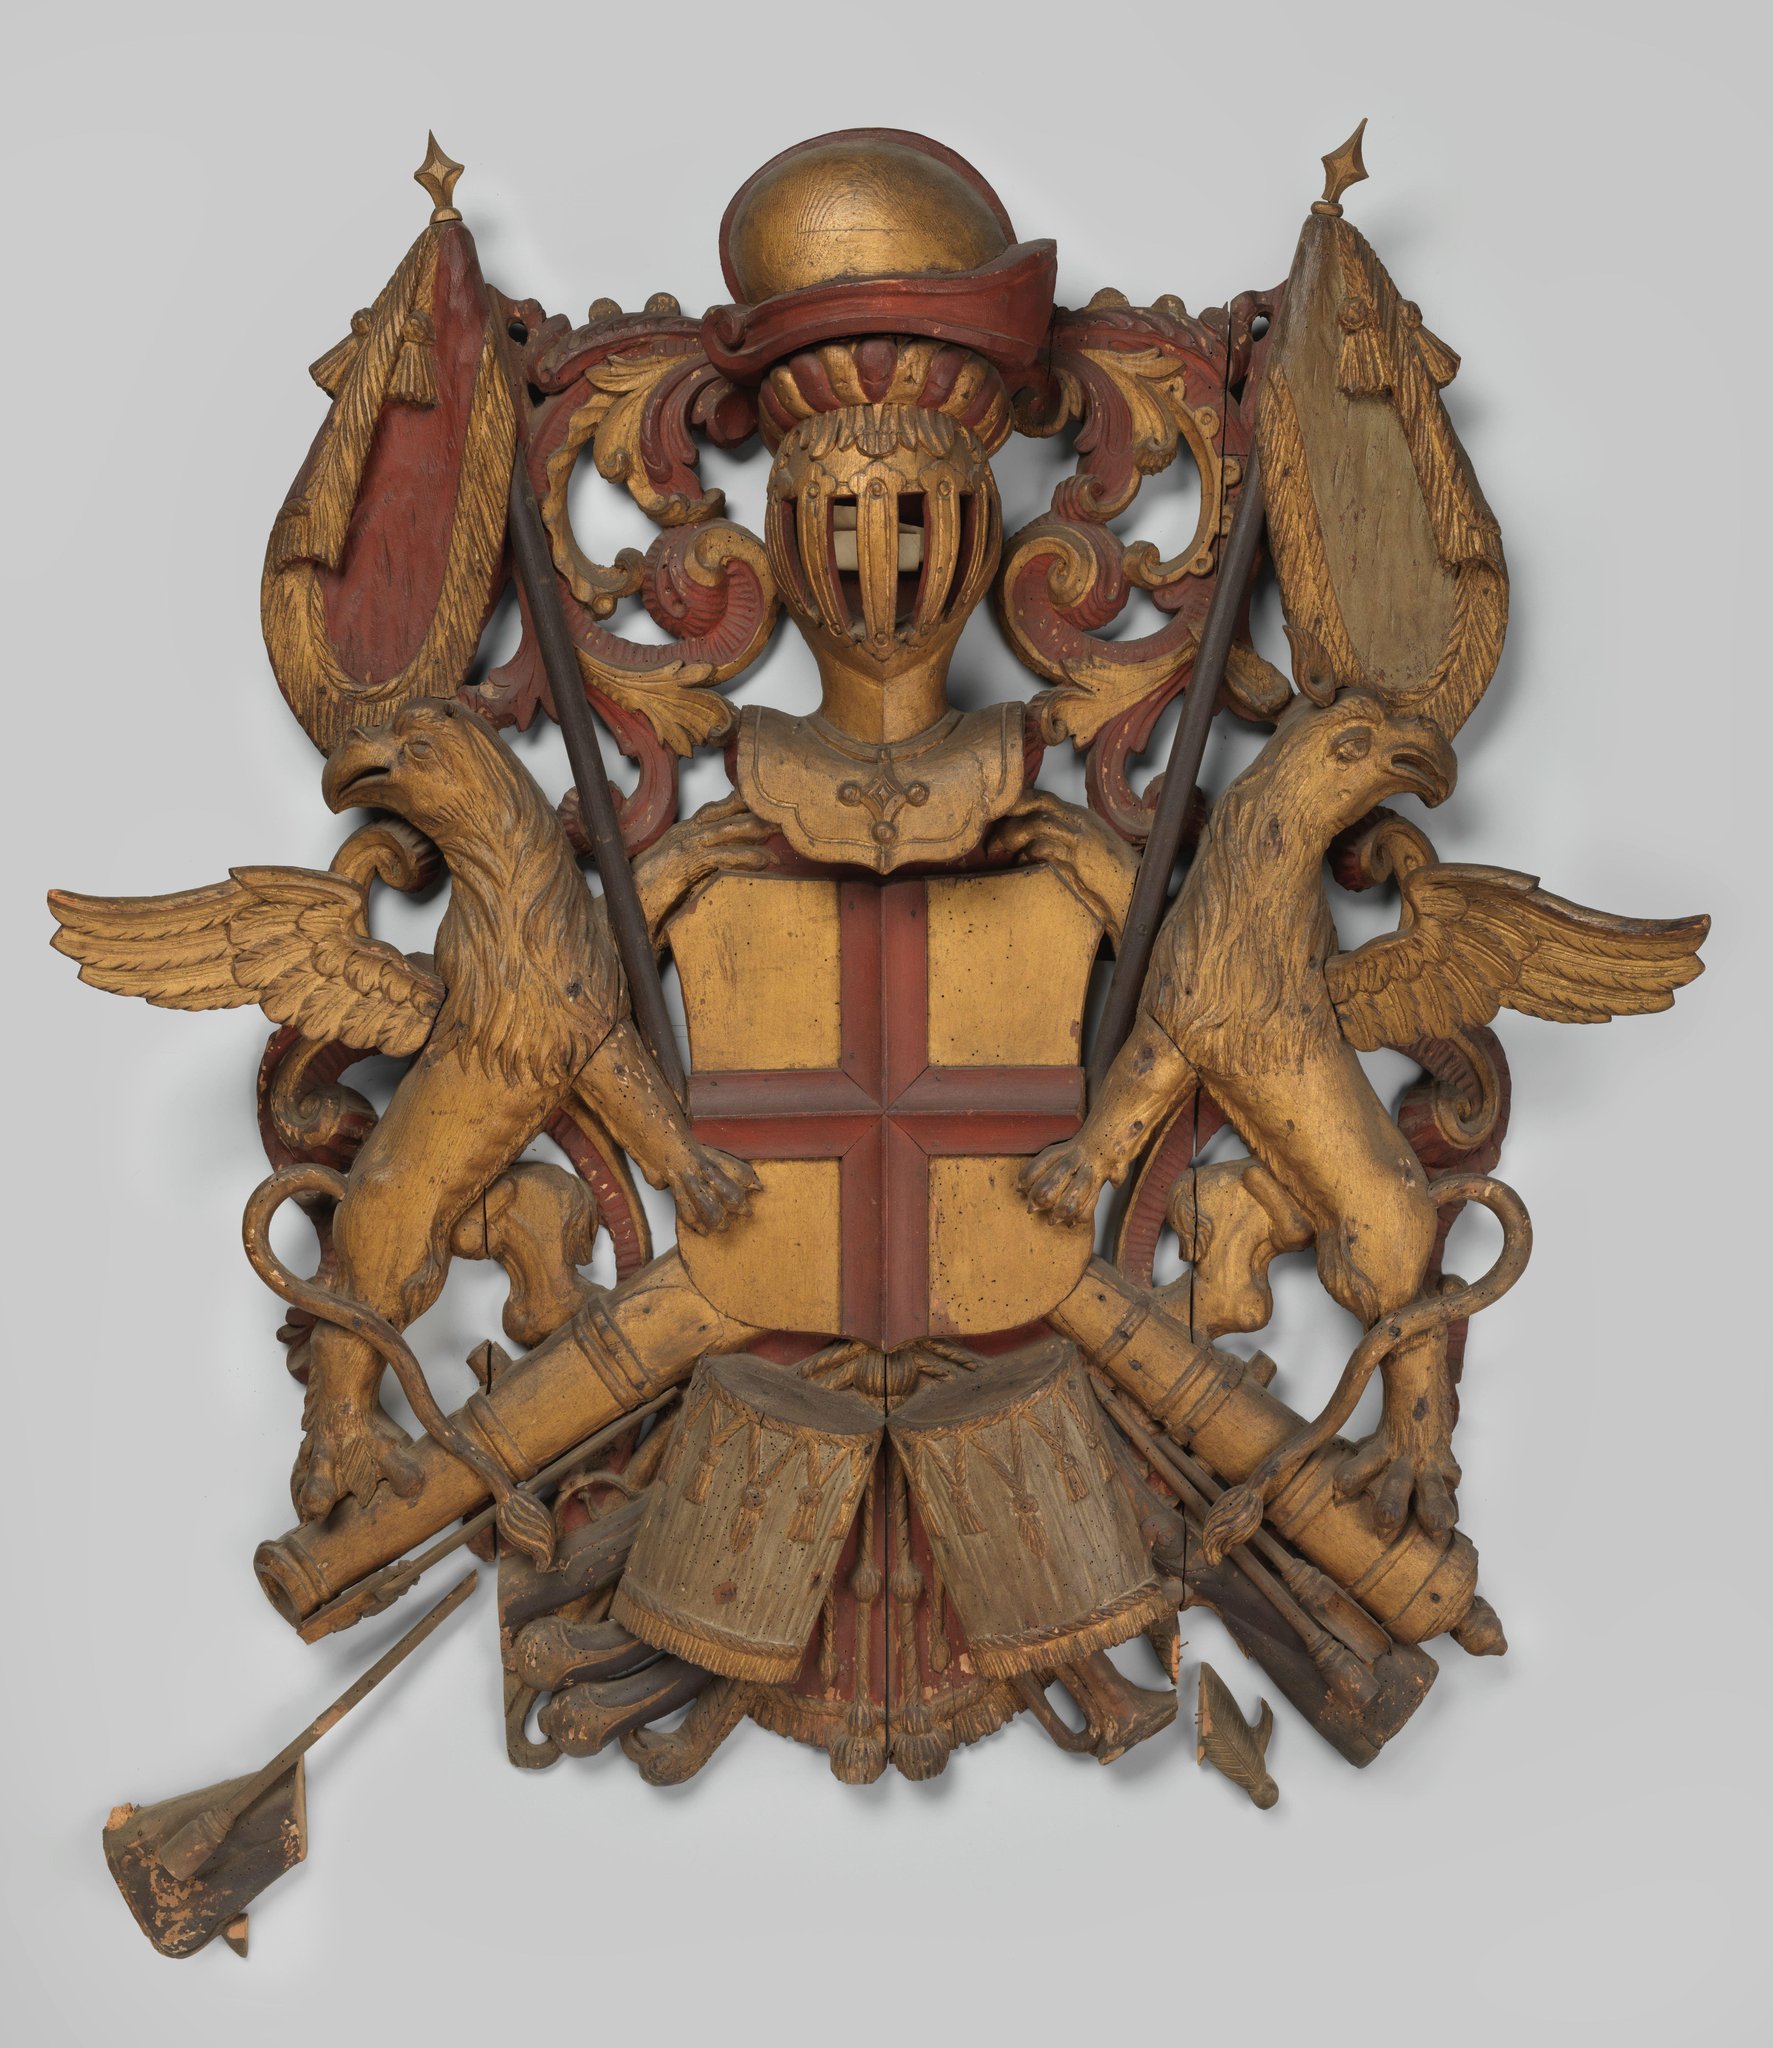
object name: wapenbord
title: Houten gepolychromeerd wapenbord wellicht van Lambert Bernard van Rechteren 1665-1725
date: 1665-1725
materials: wood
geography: netherlands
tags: lambert bernard van rechteren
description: Houten gepolychromeerd wapenbord met wapen met rood St Georgekruis op gouden veld, gehouden door twee gouden griffioenen met helm waarop als helmteken een gouden hoed of helm (hierop hoorde nog één rode struisveer). Dit wapenbord maakte deel uit van een bezit van twee wapenborden of wapenschilden waarvan éen onvindbaar is en de tweede denkelijk dit hierboven beschrevene. L.o. en r.o. is een deel van de wapentrofeeën afgebroken maar nog wel aanwezig. Idem de vleugel van de linker griffioen.